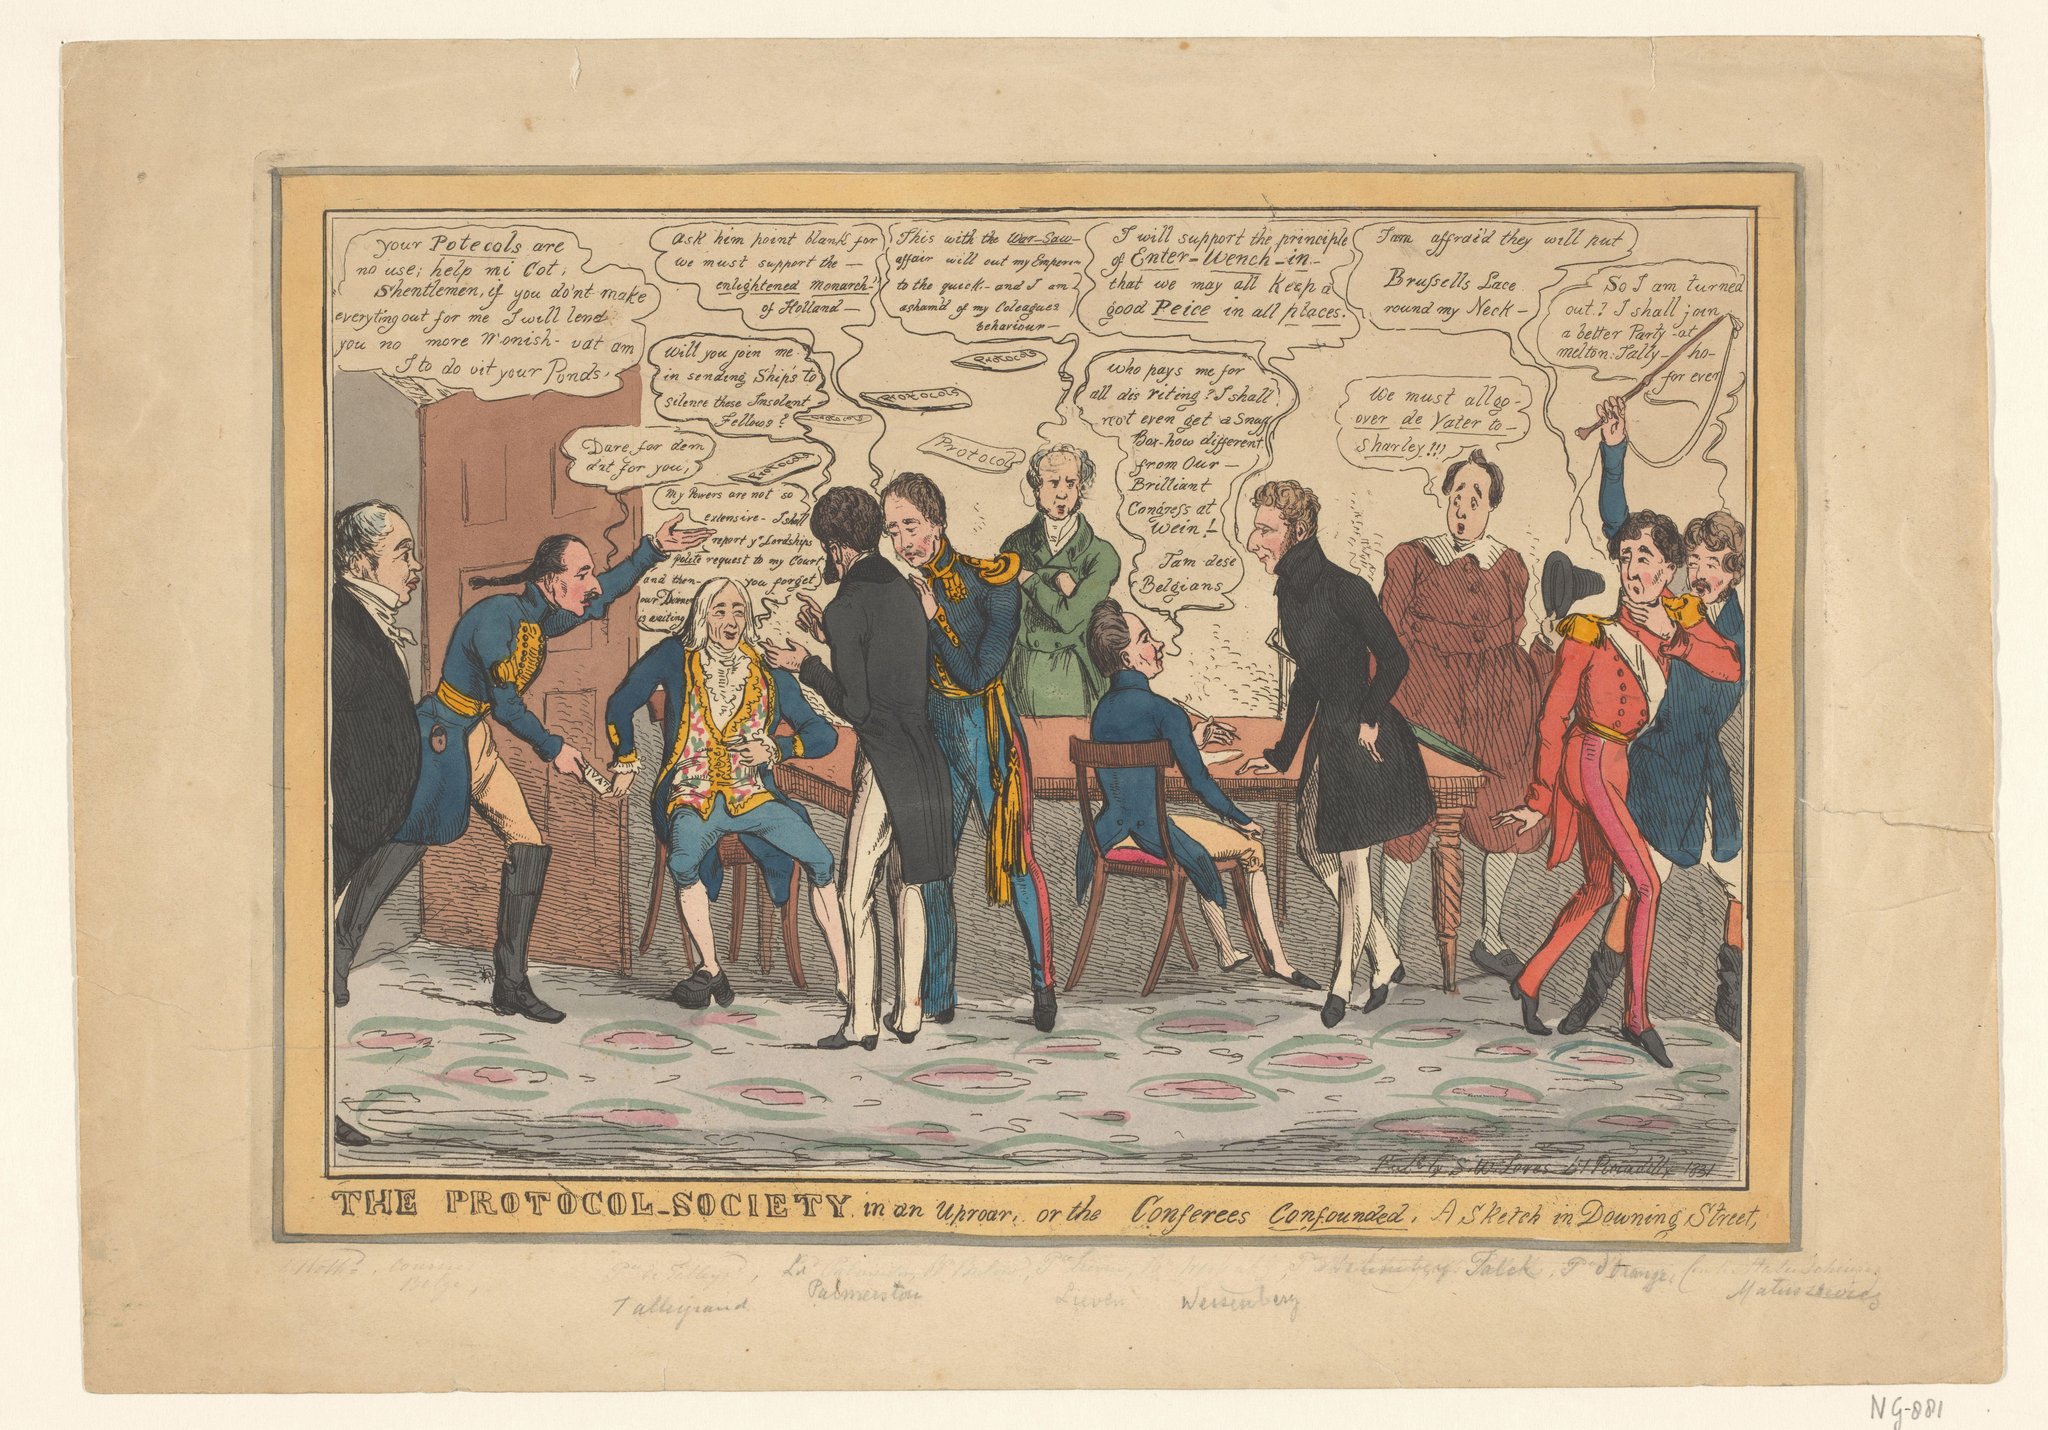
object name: print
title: The Protocol-Society in an Uproar, or the Conferees Confounded, A Sketch in Downing Street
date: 1831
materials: paper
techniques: etching, hand coloring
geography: london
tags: the hague, berlin, william i of the netherlands, paris, charles maurice hertog van talleyrand-périgord, laeken, leopold i (koning der belgen), political caricatures and satires, london, belgium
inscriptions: date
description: Spotprent op de verdeeldheid onder de Europese afgevaardigden op de Londense Conferentie over de toekomst van België in januari 1831. Uiteindelijk wordt hier het Tractaat der XVIII artikelen opgesteld. Links zit op een stoel Talleyrand in gesprek met Palmerston. Rechts een dikke Nederlander (mogelijk koning Willem I) en twee vertrekkende personen, prins Leopold met de graaf van Aerschot of de prins van Oranje. Links kijkt de bankier Nathan Rothschild toe. Met vele opschriften in het Engels.